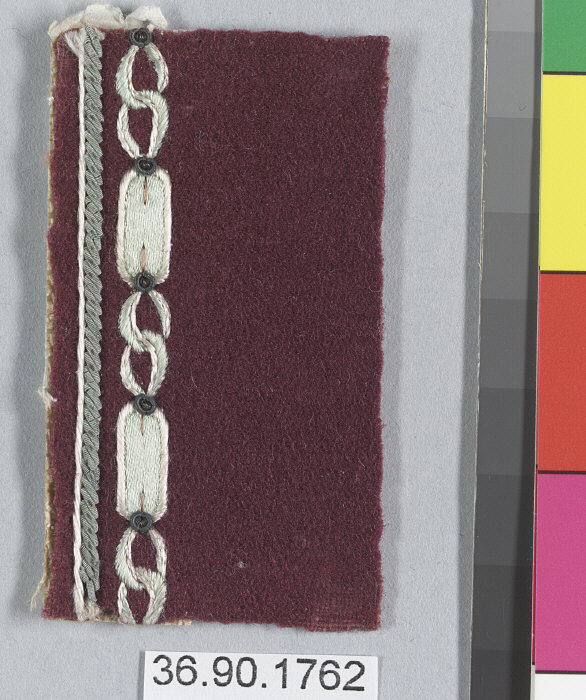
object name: sample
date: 1801-1833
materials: felt, metal thread, silk